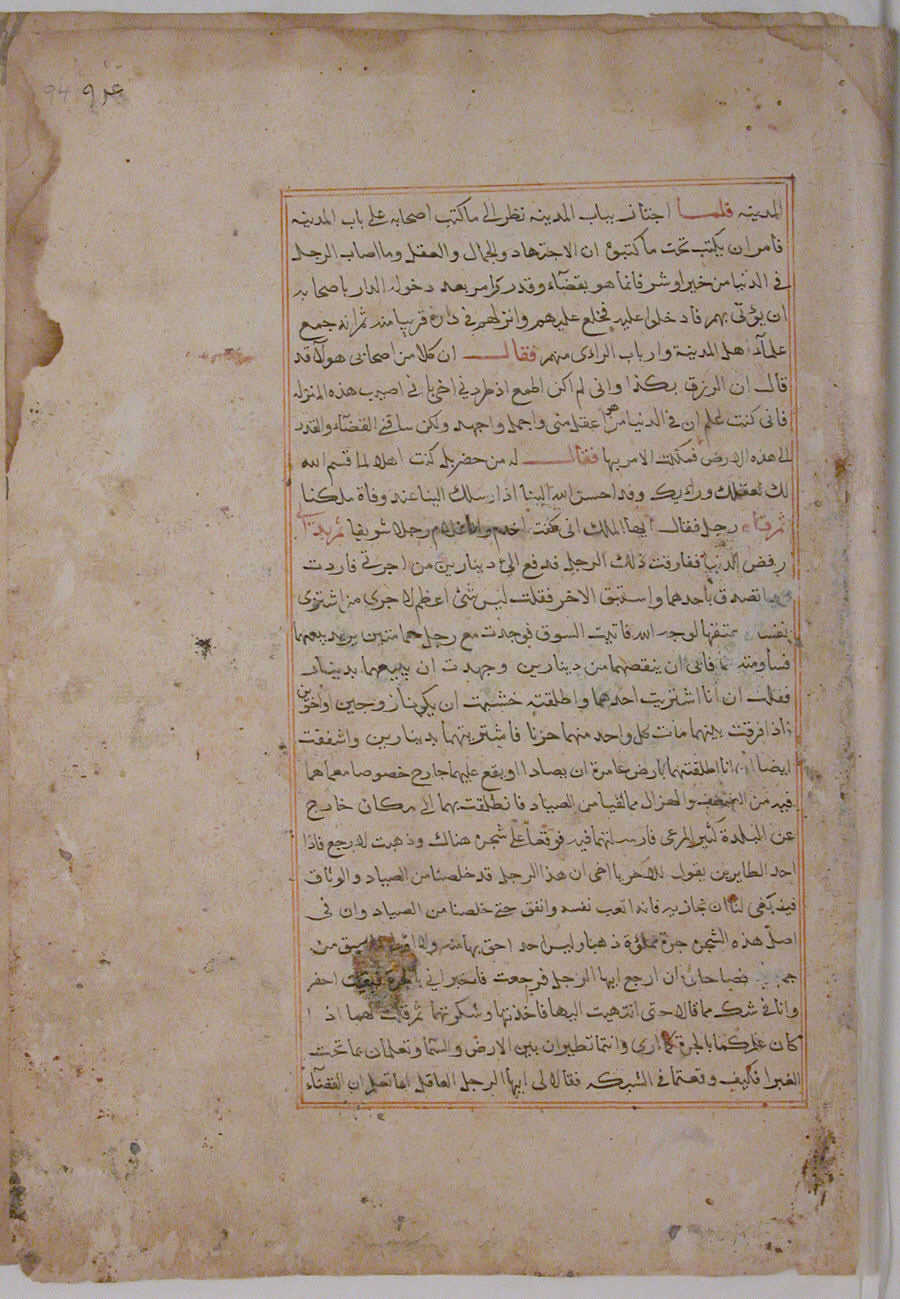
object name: folio from an illustrated manuscript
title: Page of Calligraphy from a Kalila wa Dimna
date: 1526-1550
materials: ink, paper, watercolor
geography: india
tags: arabic,calligraphy